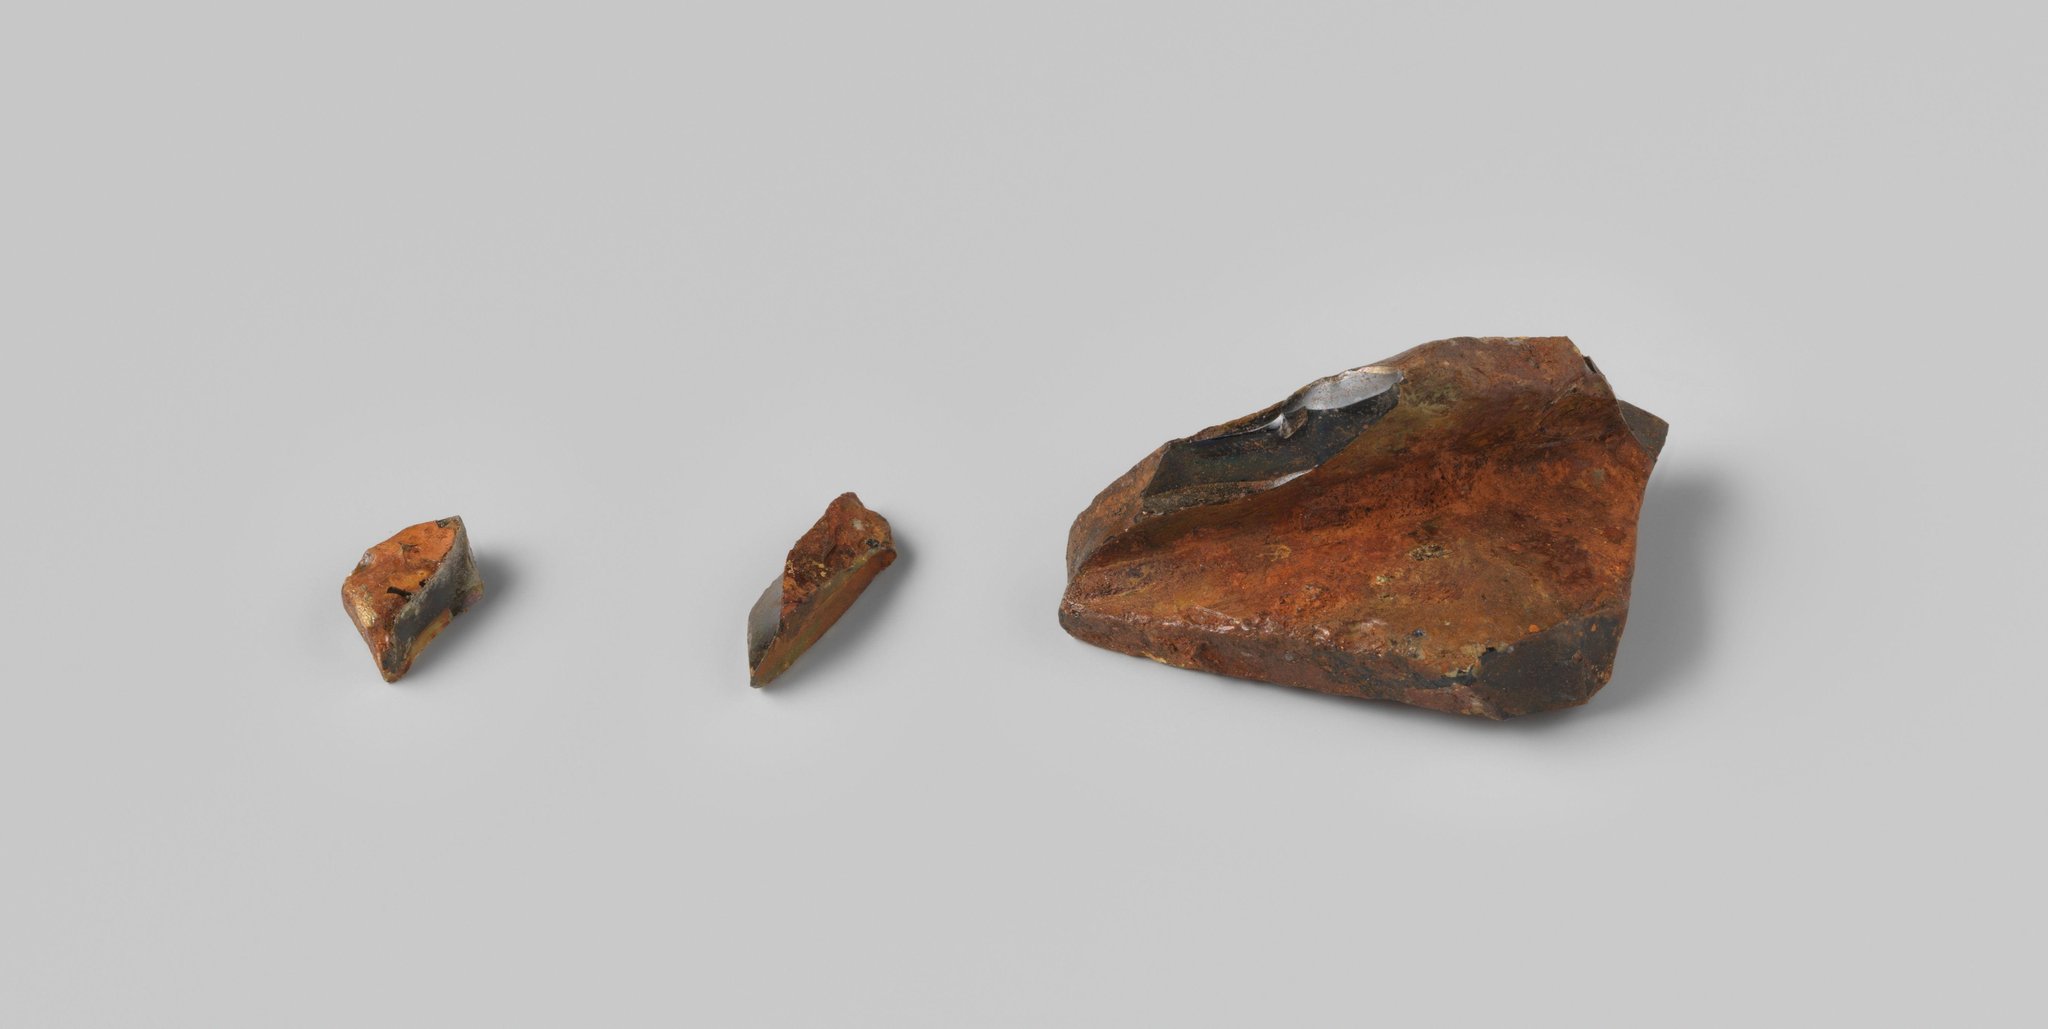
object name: case bottle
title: Scherven van een kelderfles uit het wrak van de Oostindiëvaarder Hollandia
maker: Anonymous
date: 1700-1743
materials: glass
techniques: green glass